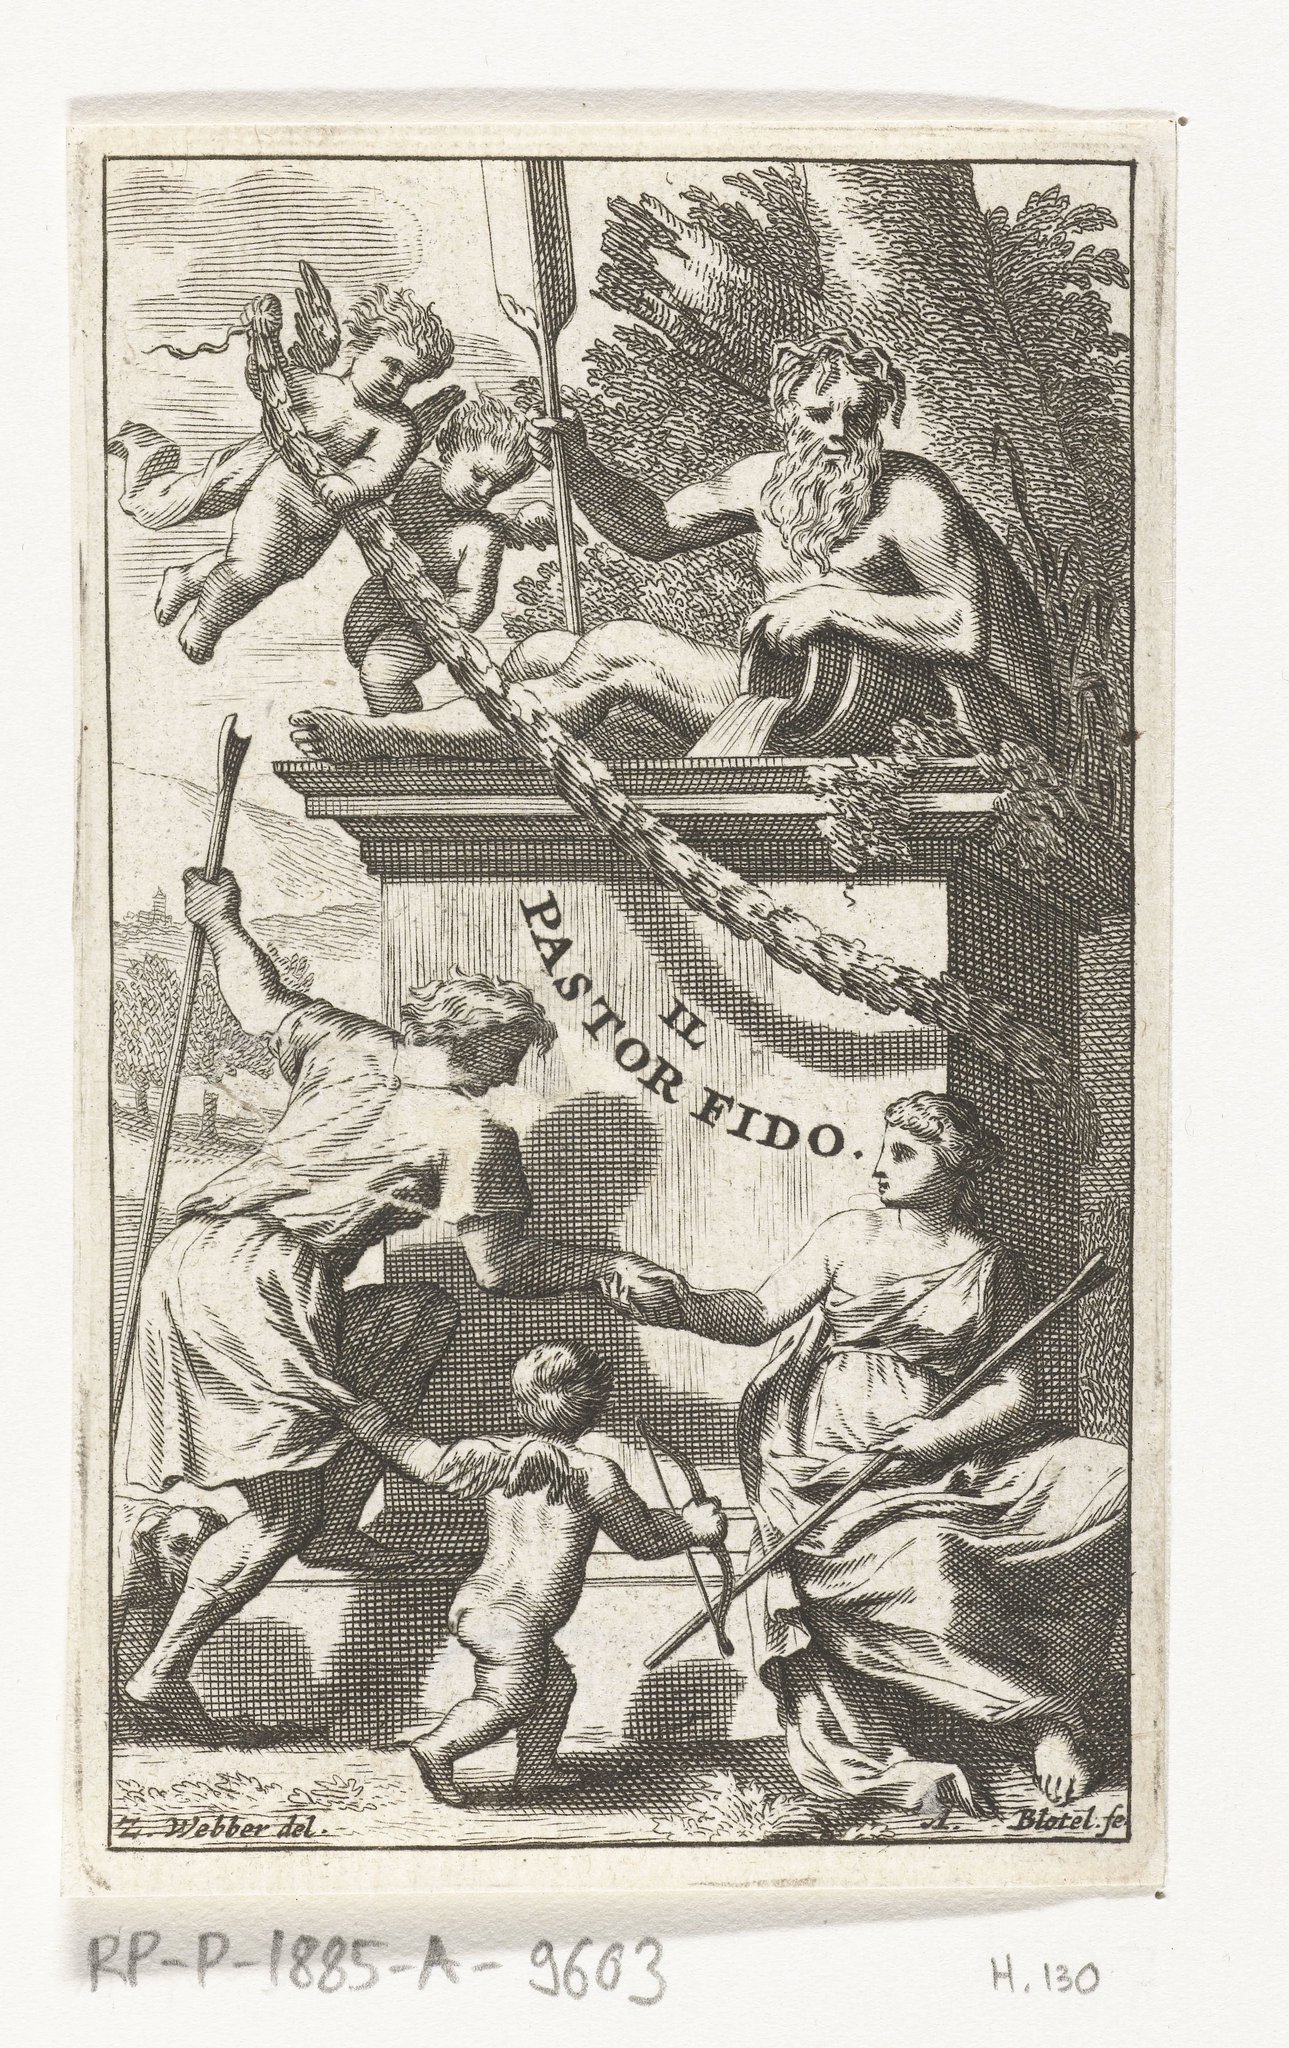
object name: titelblad, titelpagina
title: Titelpagina voor G.B. Guarini, Il pastor fido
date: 1670-1690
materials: paper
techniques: engraving, etching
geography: amsterdam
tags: herding, herdsman, herdswoman, shepherd, shepherdess, cowherd, etc., pastorals, arcadian scenes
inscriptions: collector's mark: Lugt 2228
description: Titelpagina voor een Italiaanse of Franse editie van G.B. Guarini, Il pastor fido. Mogelijk de Franse editie: Le berger fidele, Keulen, P. Marteau, 1677 (fictief adres, eigenlijk gedrukt te Leiden bij de gebroeders Hackius).